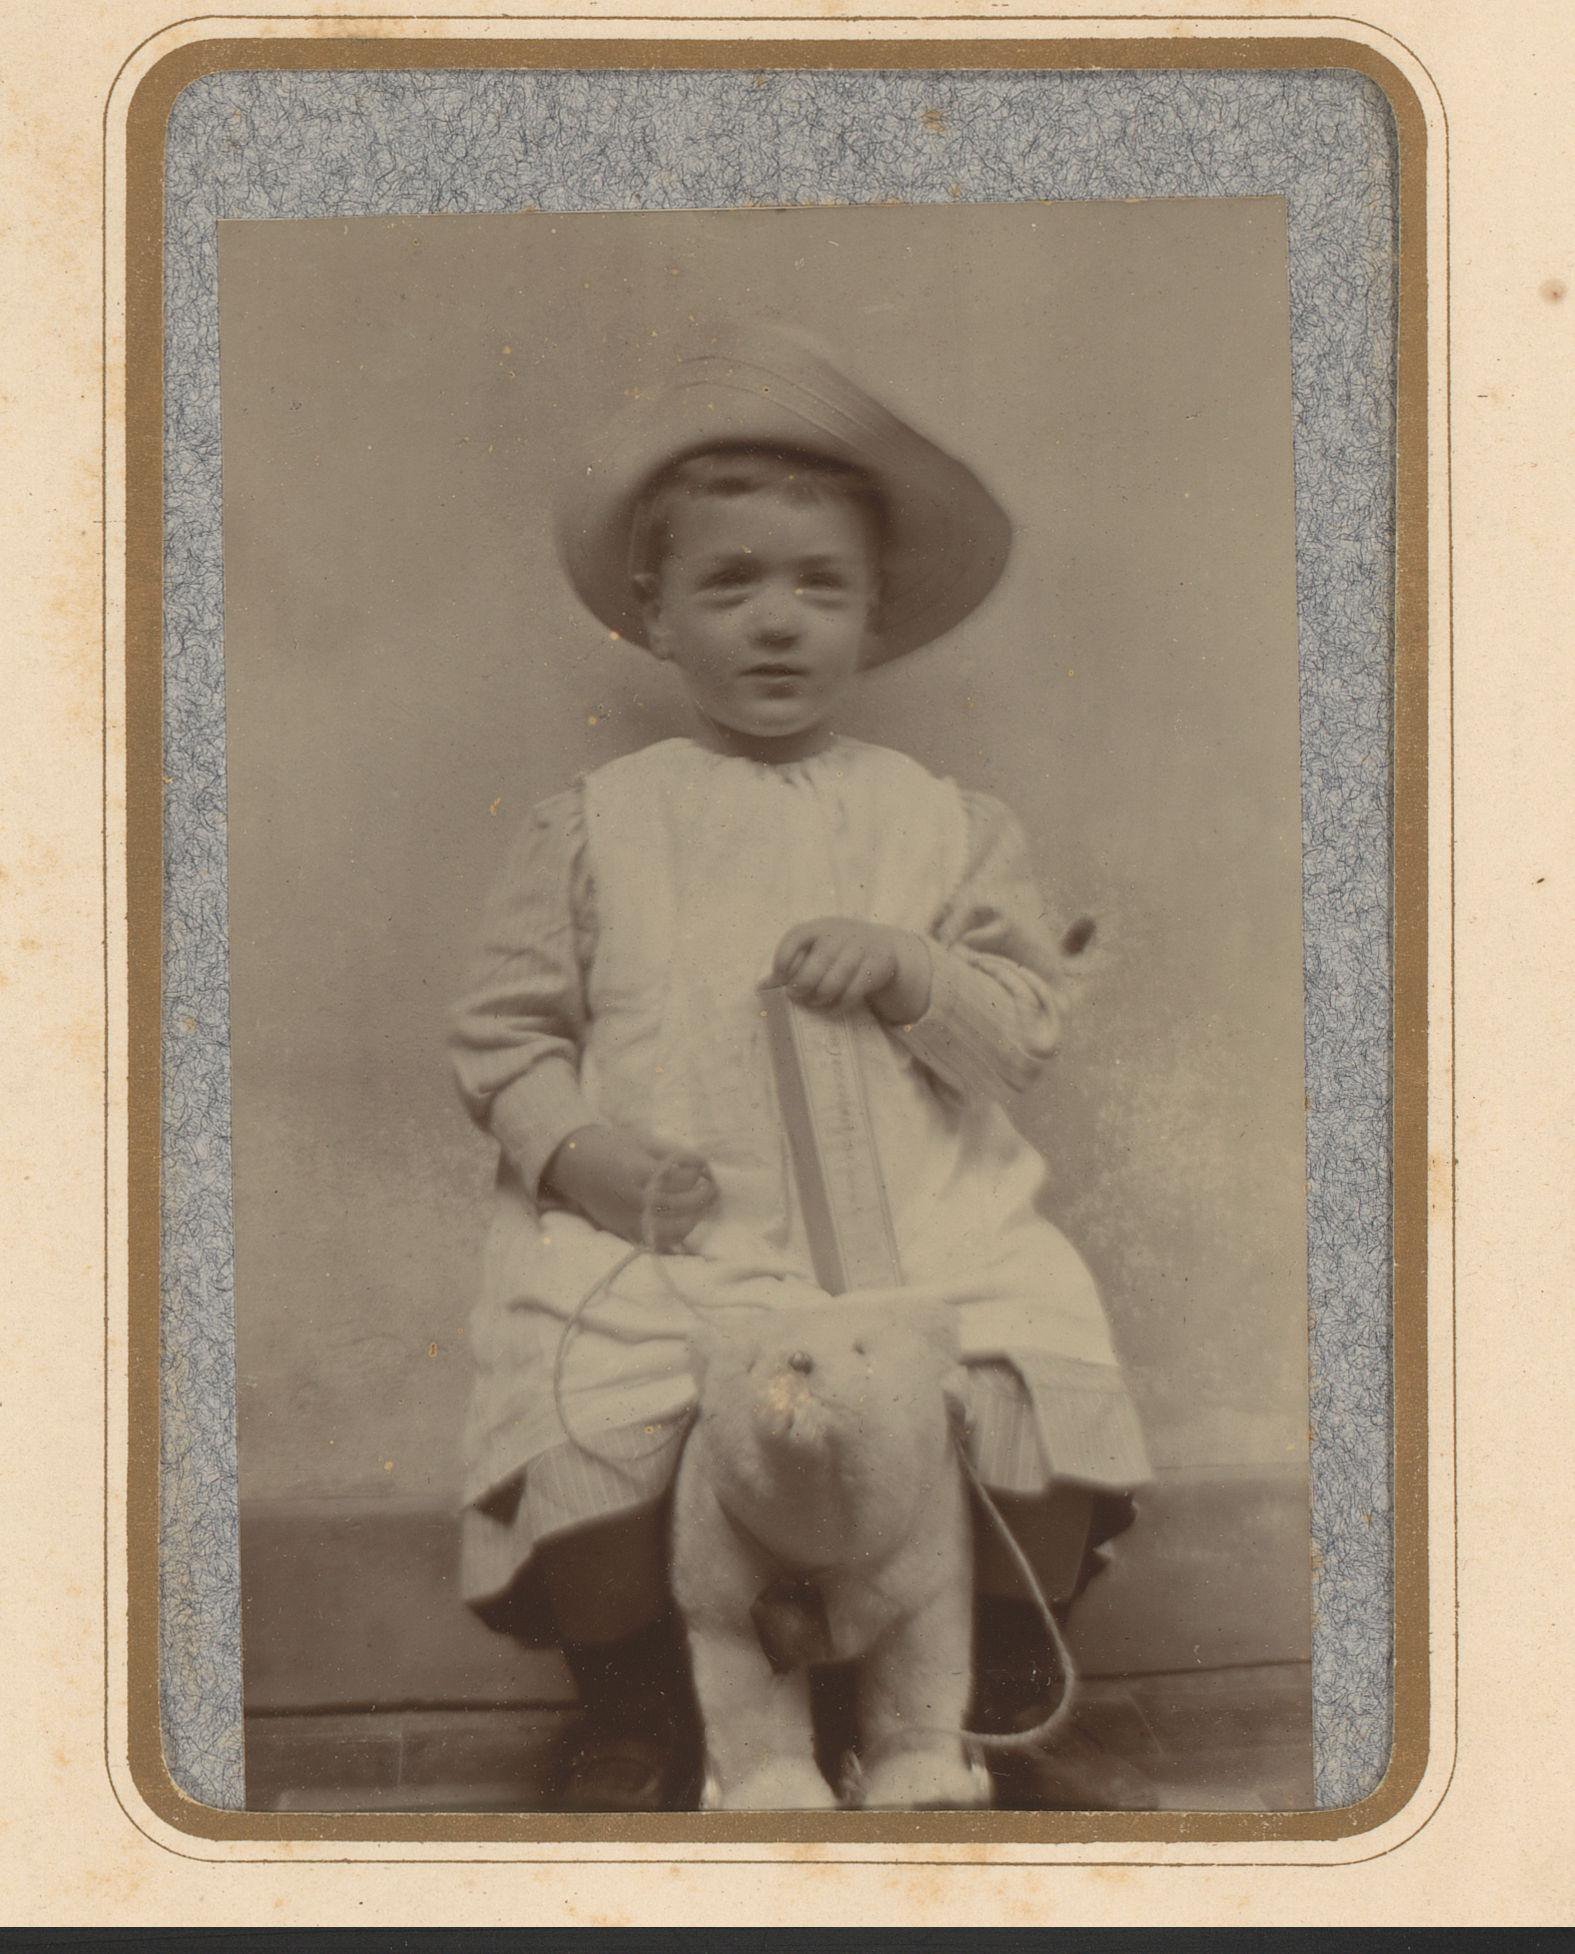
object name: photograph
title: Portret van een kleuter zittend op een speelgoedbeer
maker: Anonymous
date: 1880-1920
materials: cardboard, photographic support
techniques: daylight paper print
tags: (playing with) toy animals, child (at home)